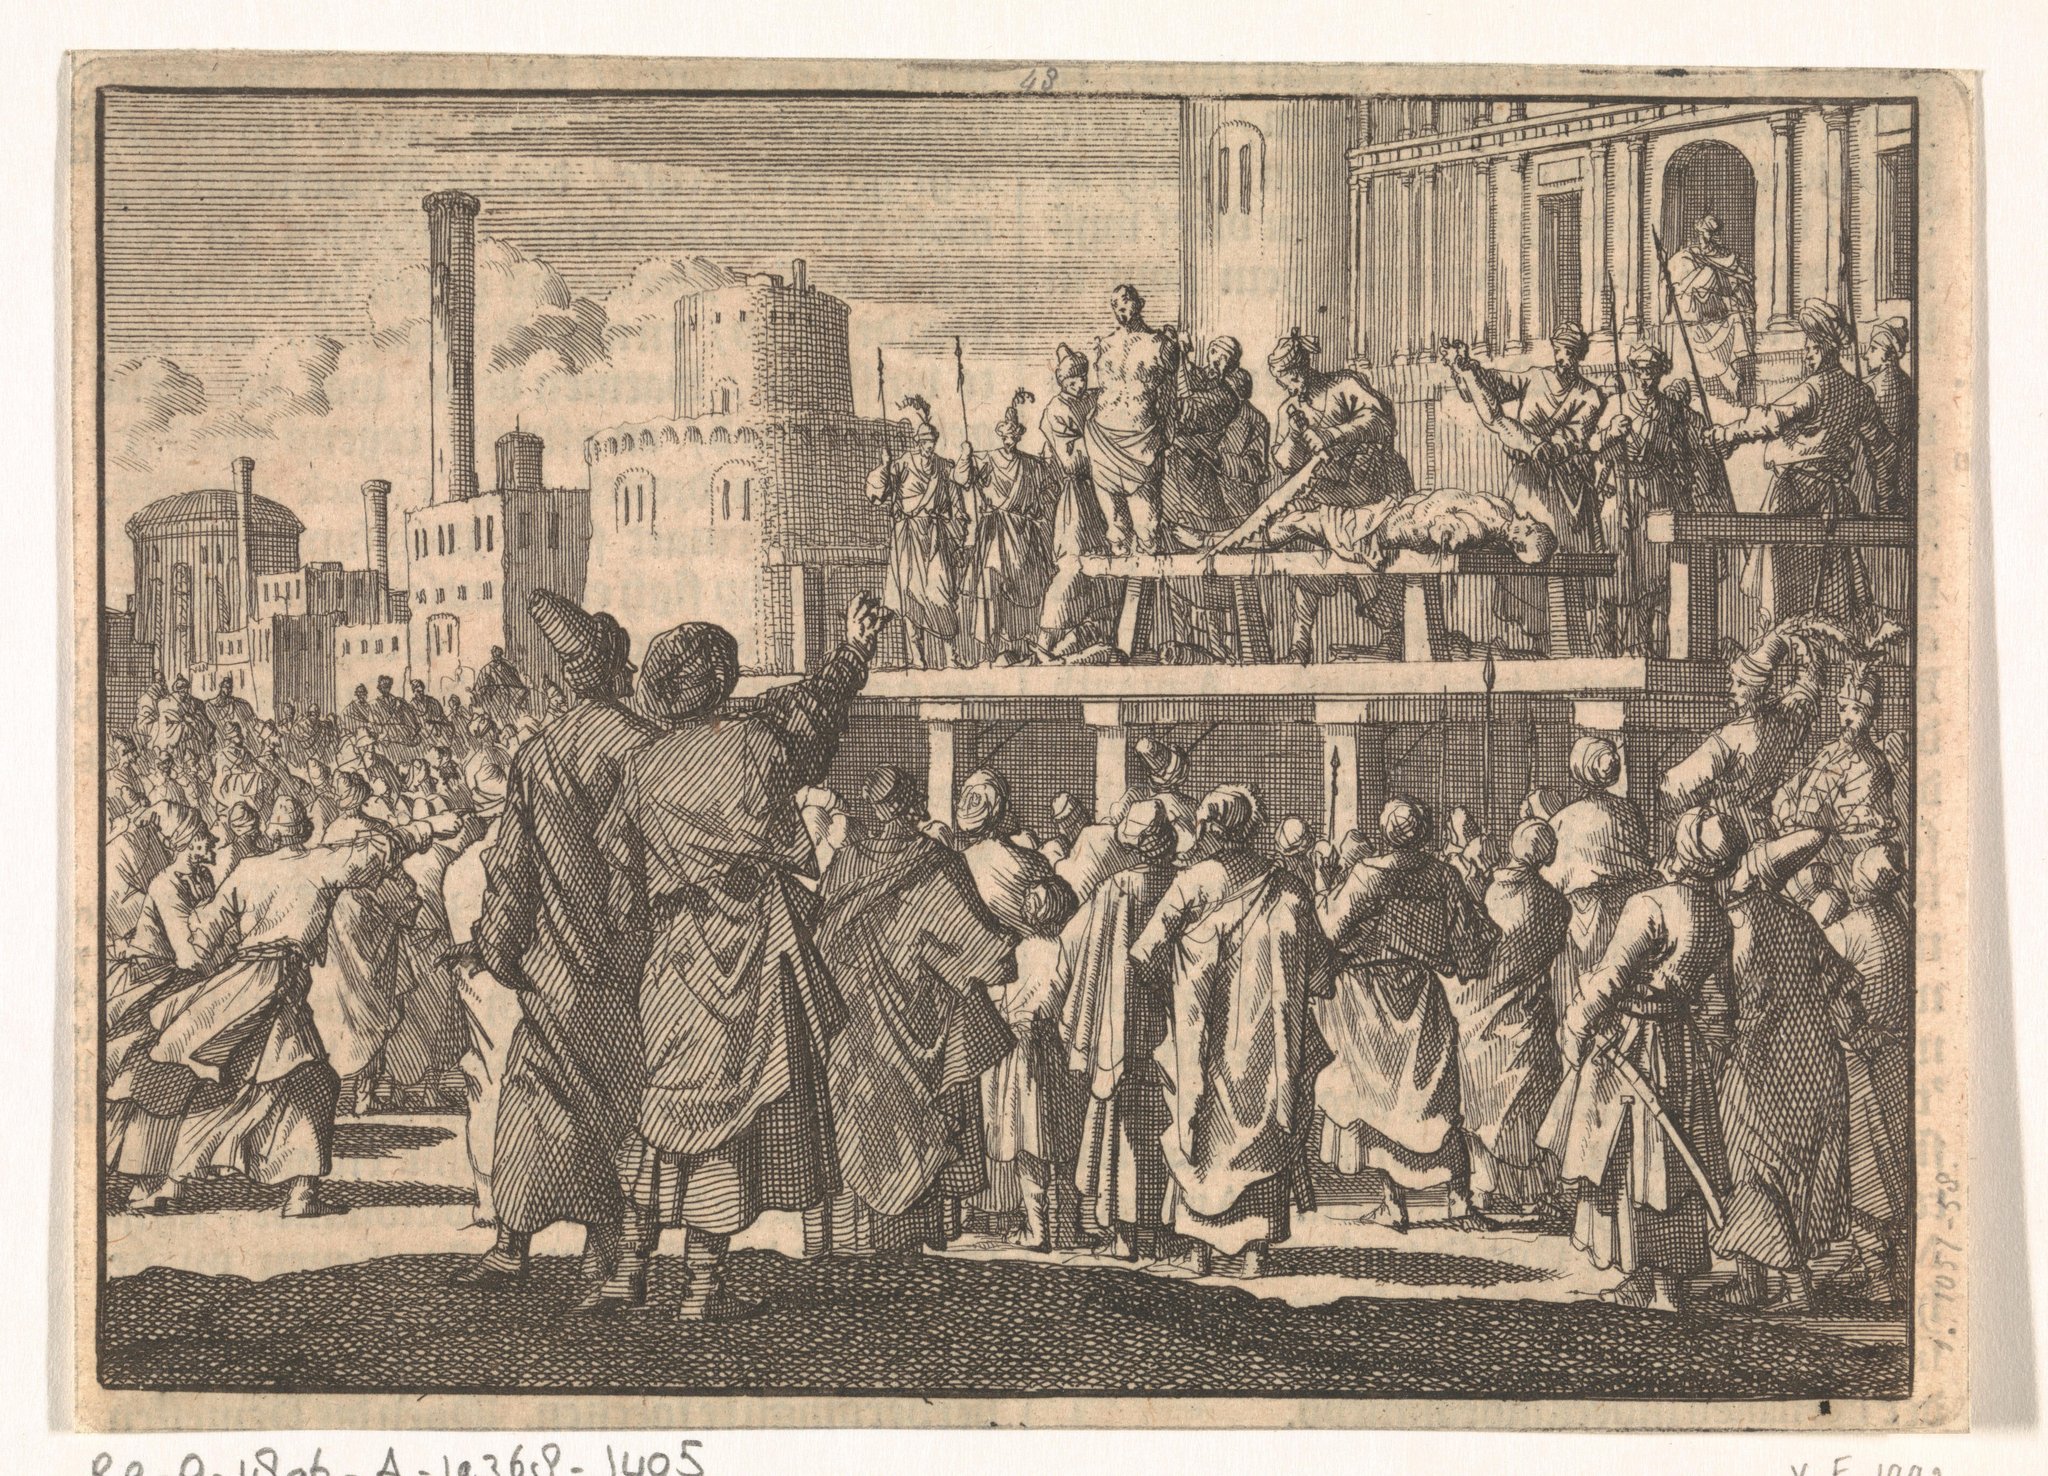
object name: print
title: Sultan Murat IV laat van twee mannen armen en benen afhakken omdat zij hadden gerookt, ca. 1630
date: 1698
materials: paper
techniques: etching, letterpress printing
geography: amsterdam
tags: violent death by removal of parts of the body by cutting, sawing, tearing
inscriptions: collector's mark: Lugt 2228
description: Illustratie uit: Gottfried, Johann Ludwig. Historische kronyck; vervattende een (...) beschrijvingh der aldergedenckwaerdigste geschiedenissen des weerelds, van den aenvangh der scheppingh tot (...) 1576 (2 delen). Leiden: Pieter van der Aa, 1698, dl. I, p. 1057.